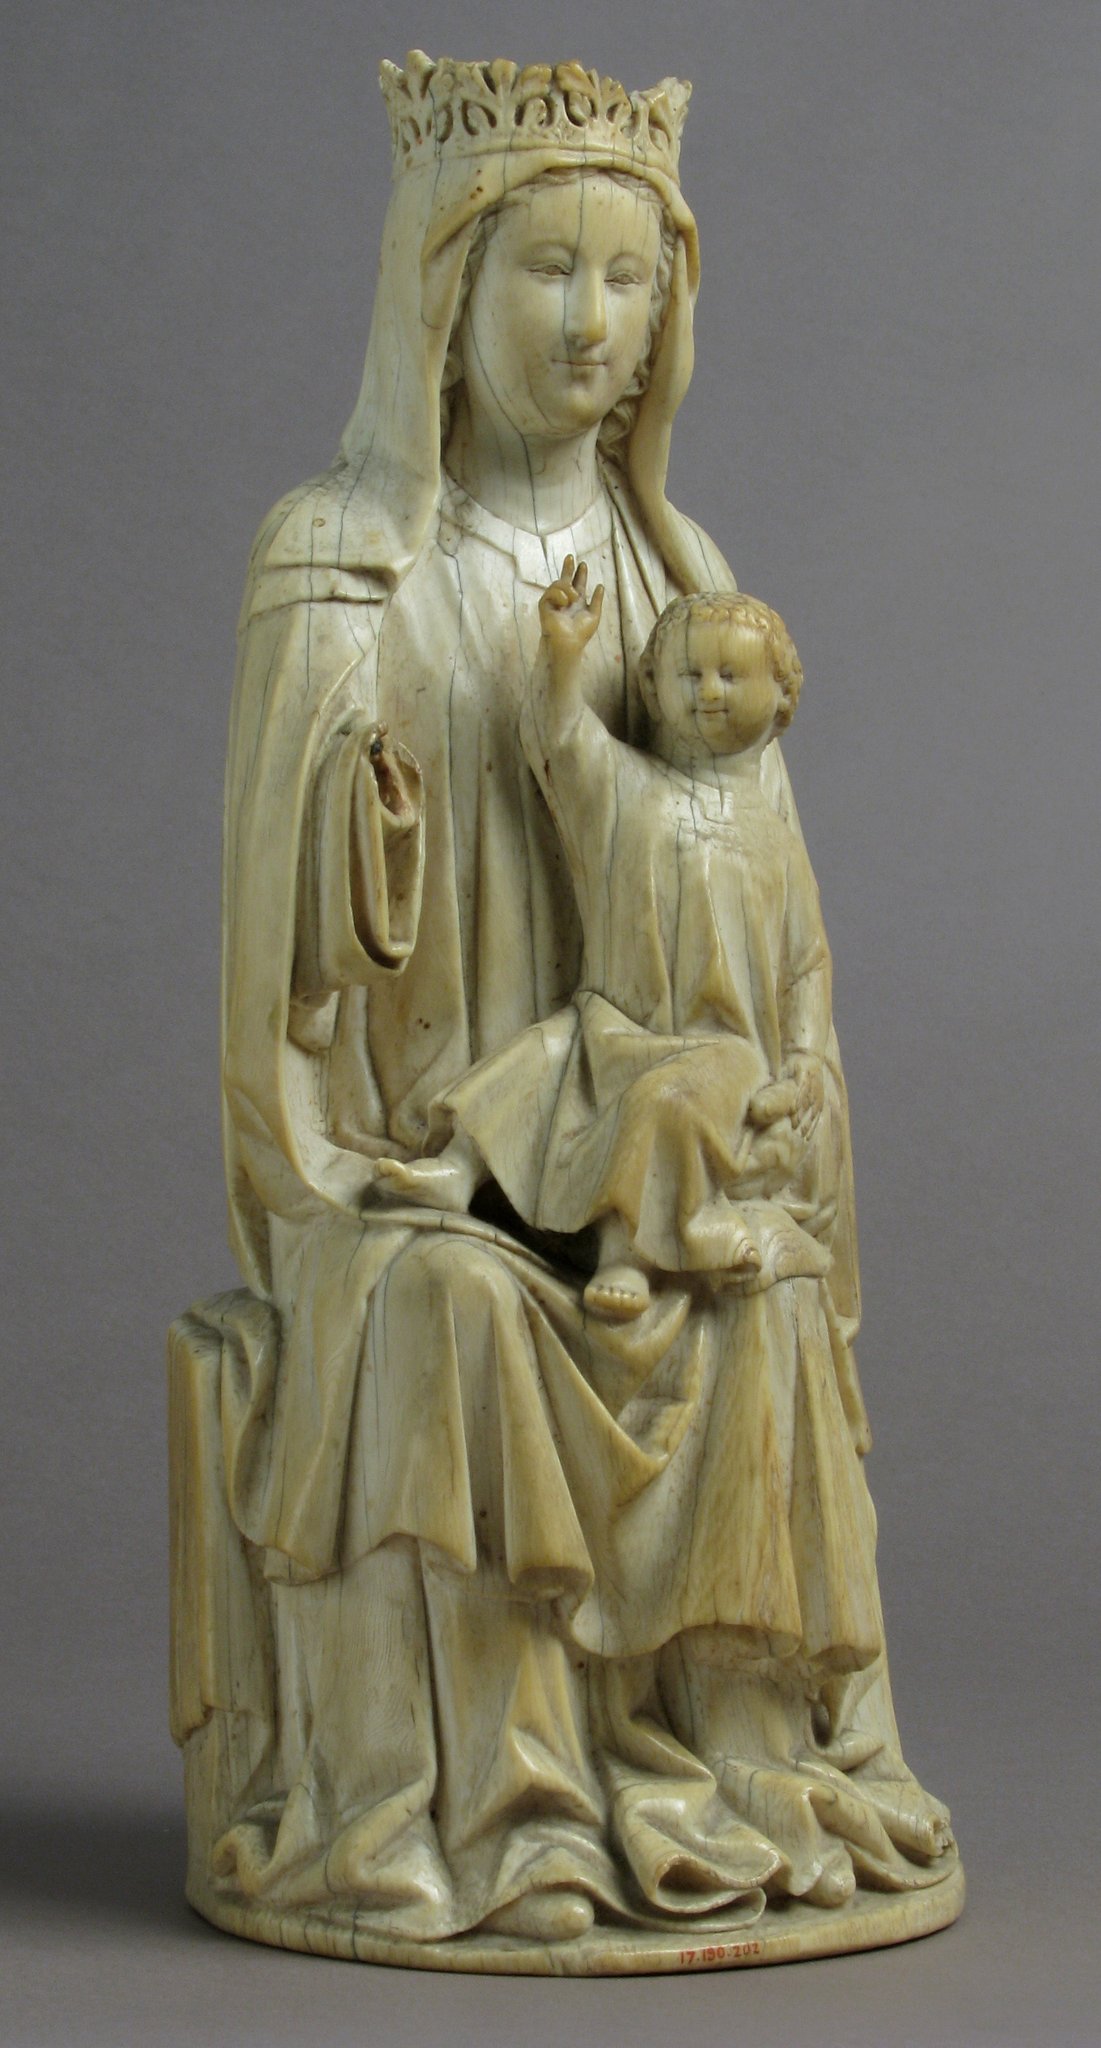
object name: statuette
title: Virgin and Child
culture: french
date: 1301-1400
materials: ivory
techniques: polychromy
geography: france